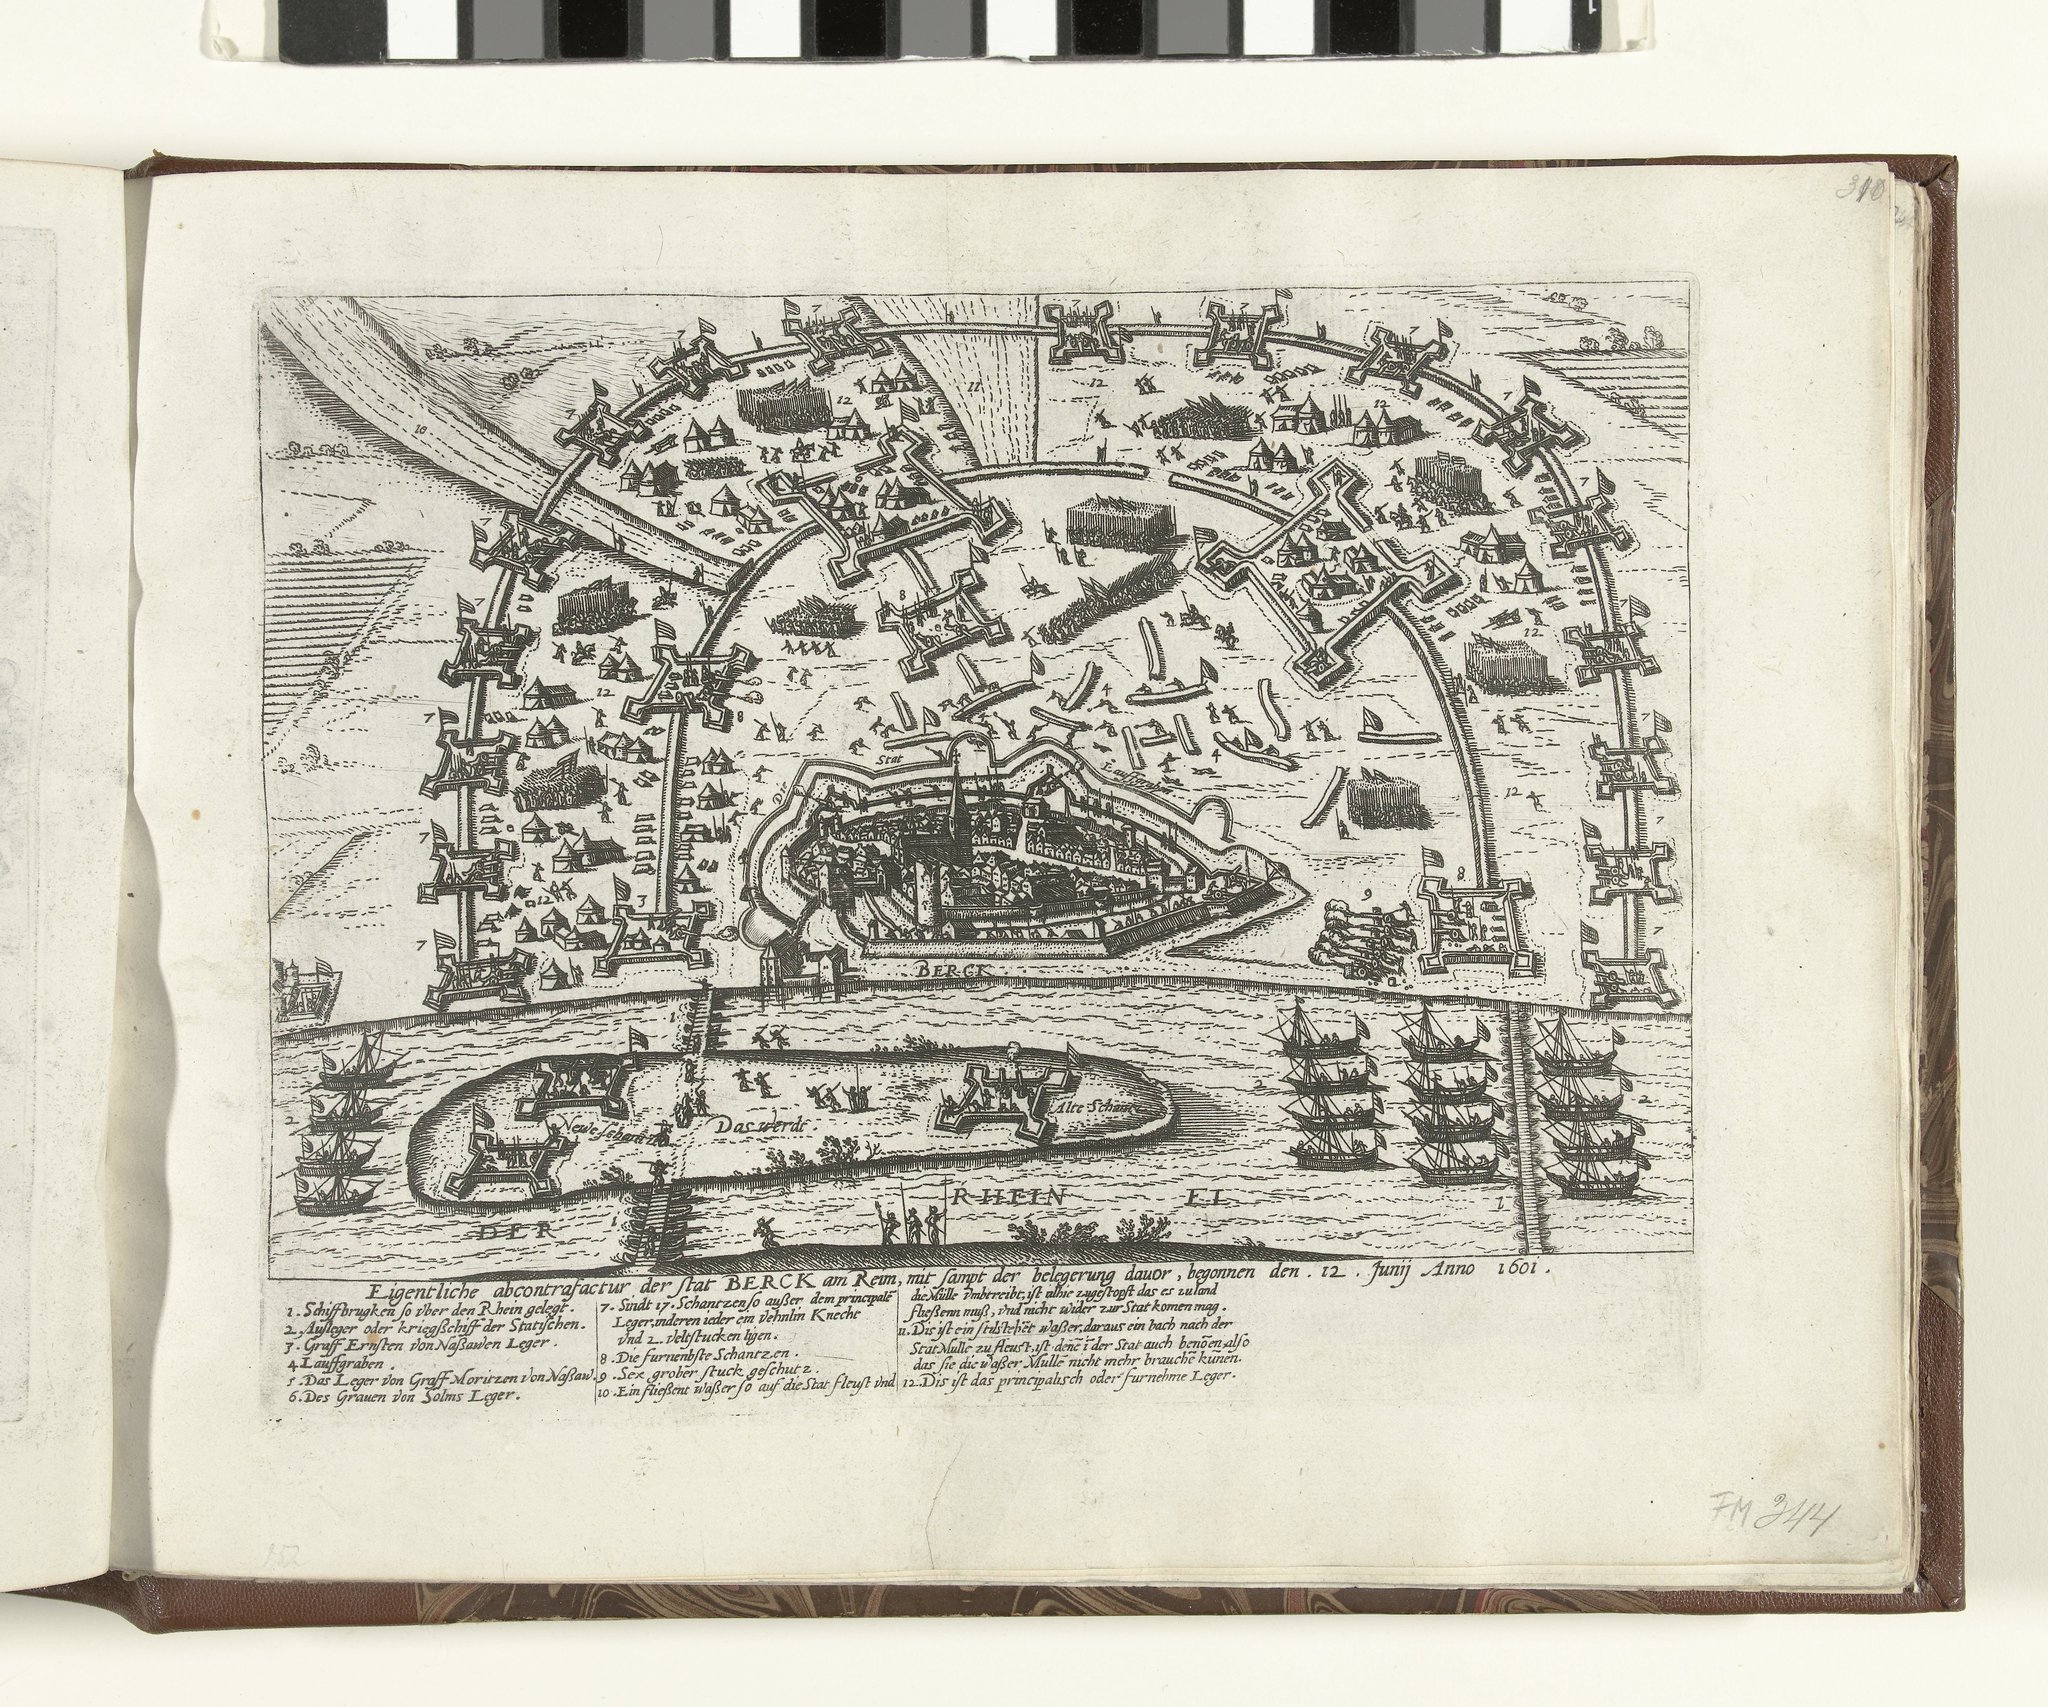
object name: print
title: Serie 10: Nederlandse en Buitenlandse Gebeurtenissen, 1587-1612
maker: frans hogenberg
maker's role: print maker, publisher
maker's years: 1538-1590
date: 1601-1603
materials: paper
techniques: etching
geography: cologne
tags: siege, position war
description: Beleg van Rheinberg door het Staatse leger onder prins Maurits, aanvang 12 juni 1601. Plan van de stad en omgeving met de stellingen van de belegeraars. Onder de voorstelling de titel en de legenda van de cijfers 1-12, in het Duits. Ongenummerd.